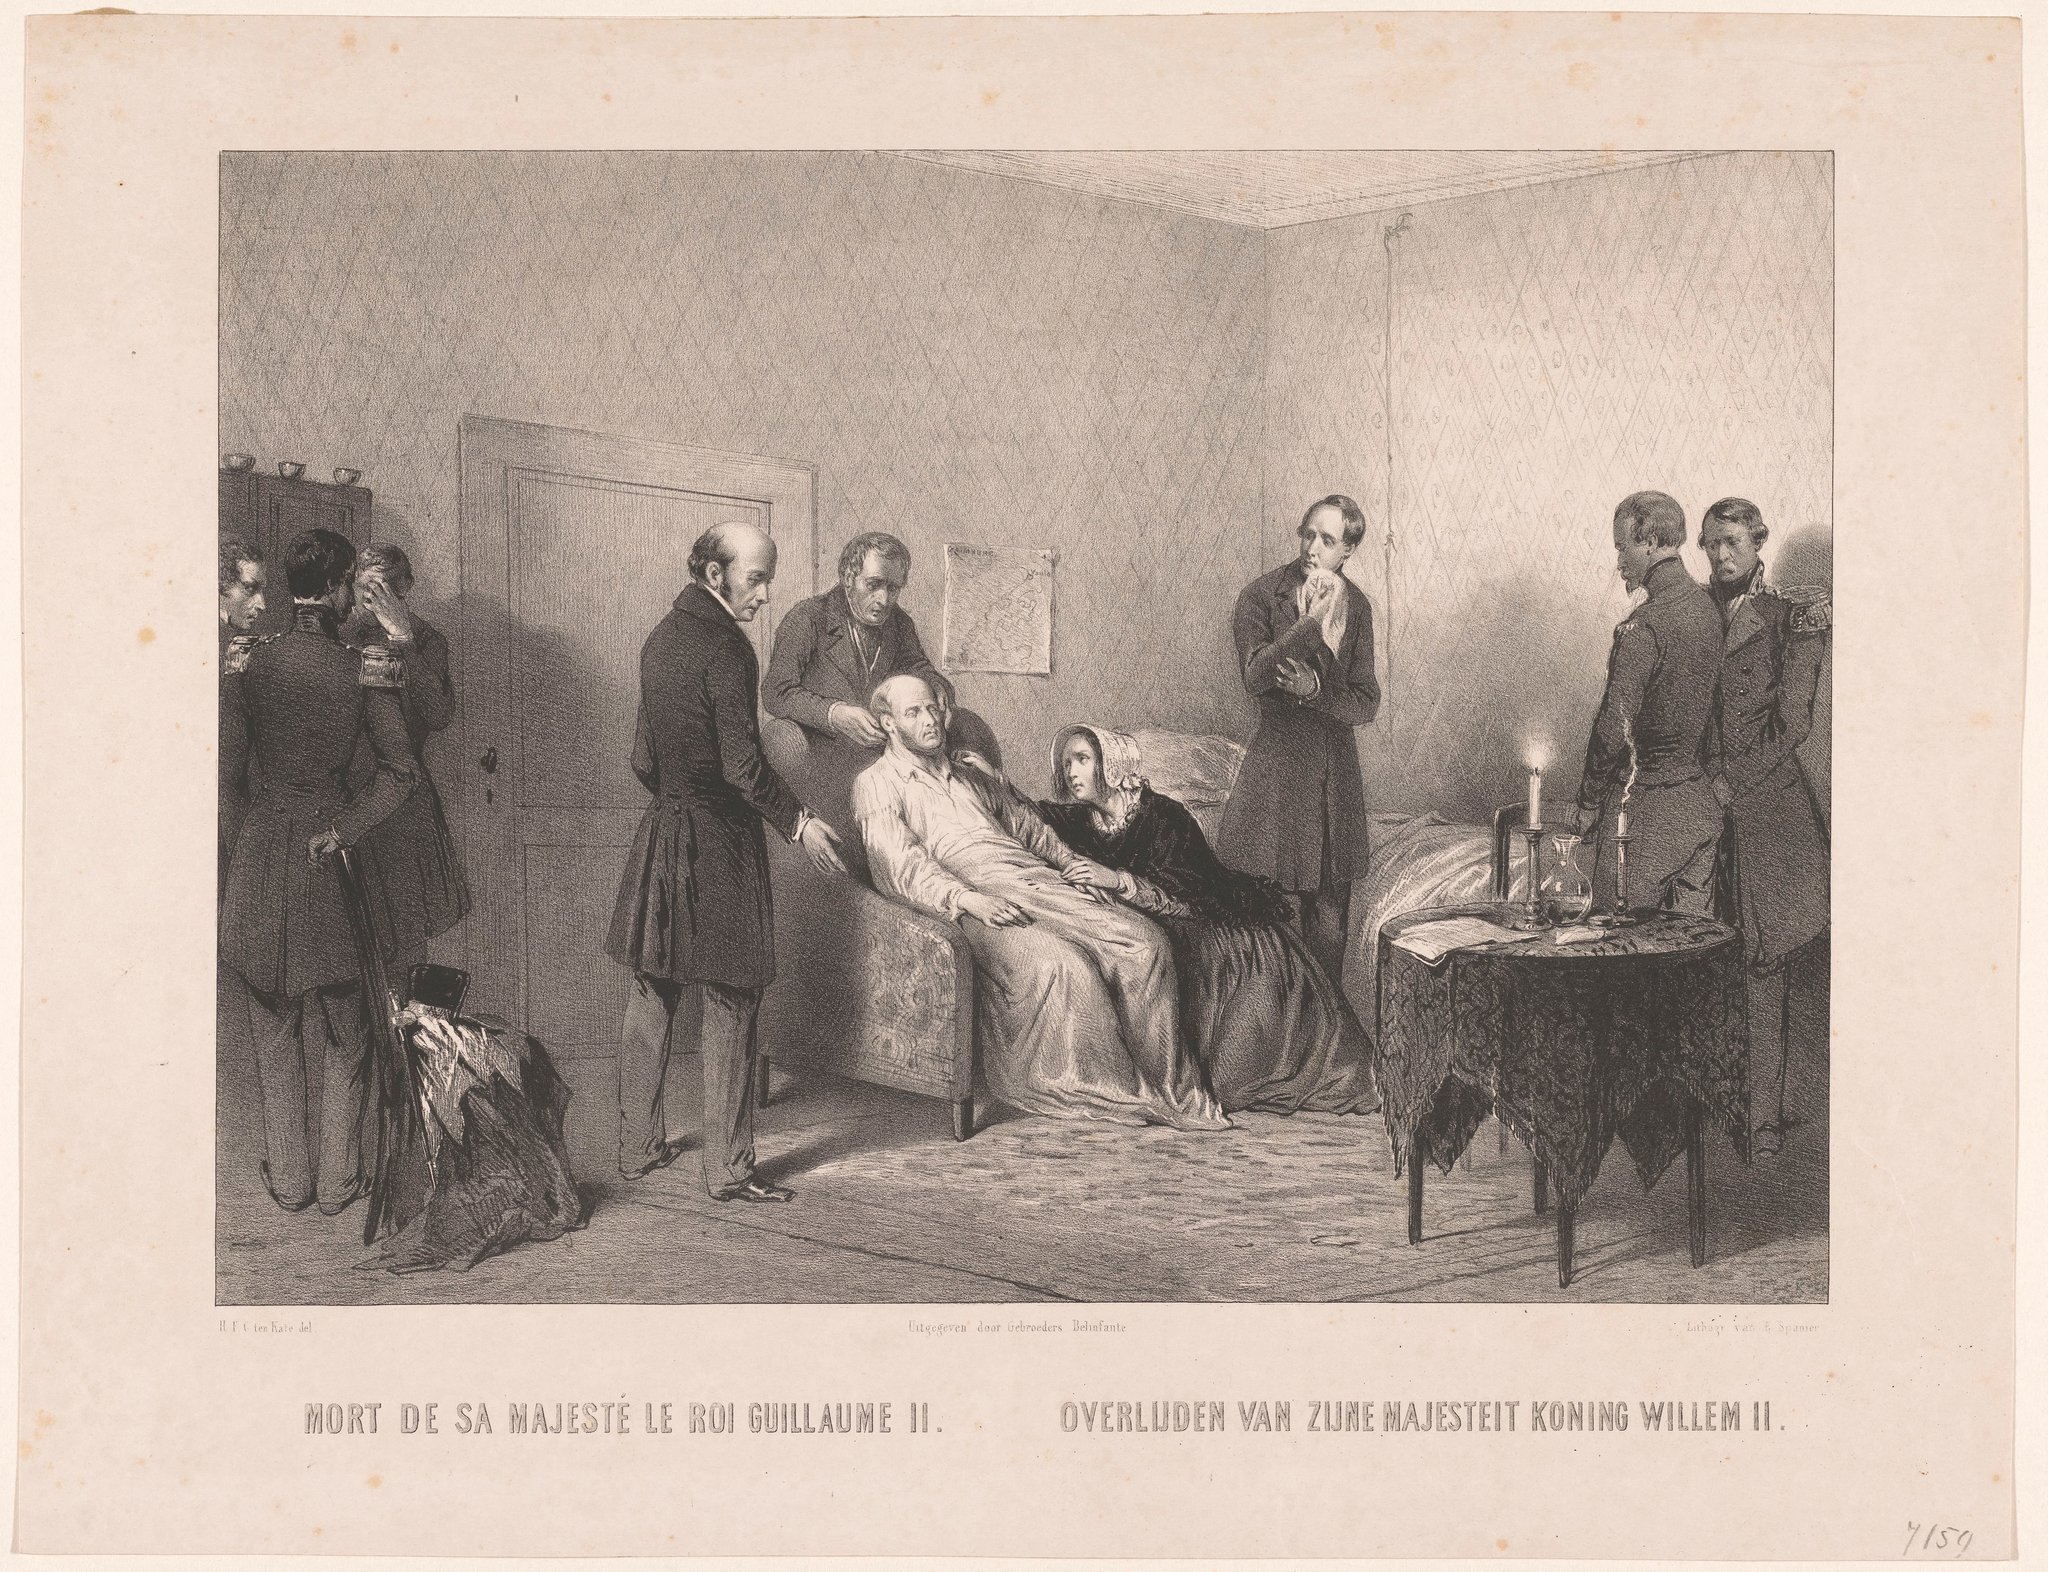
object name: print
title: Overlijden van koning Willem II, 1849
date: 1849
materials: paper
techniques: lithograph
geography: netherlands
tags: anna paulowna romanowa, the hague, william ii of the netherlands, hendrik (prins der nederlanden), deathbed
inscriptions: collector's mark: Lugt 2228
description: Het overlijden van koning Willem II in Tilburg op 17 maart 1849. De koning sterft zittend in een stoel in een kamer, aan zijn voeten knielt zijn echtgenote Anna Paulowna. Achter haar staat prins Hendrik, rechts de adjudanten Coehoorn en Merkes. Links van de koning de kamerheer Matthijs, de arts Everard. Meer naar links de artsen Maes en Van Hees en de kamerheer Aerts.